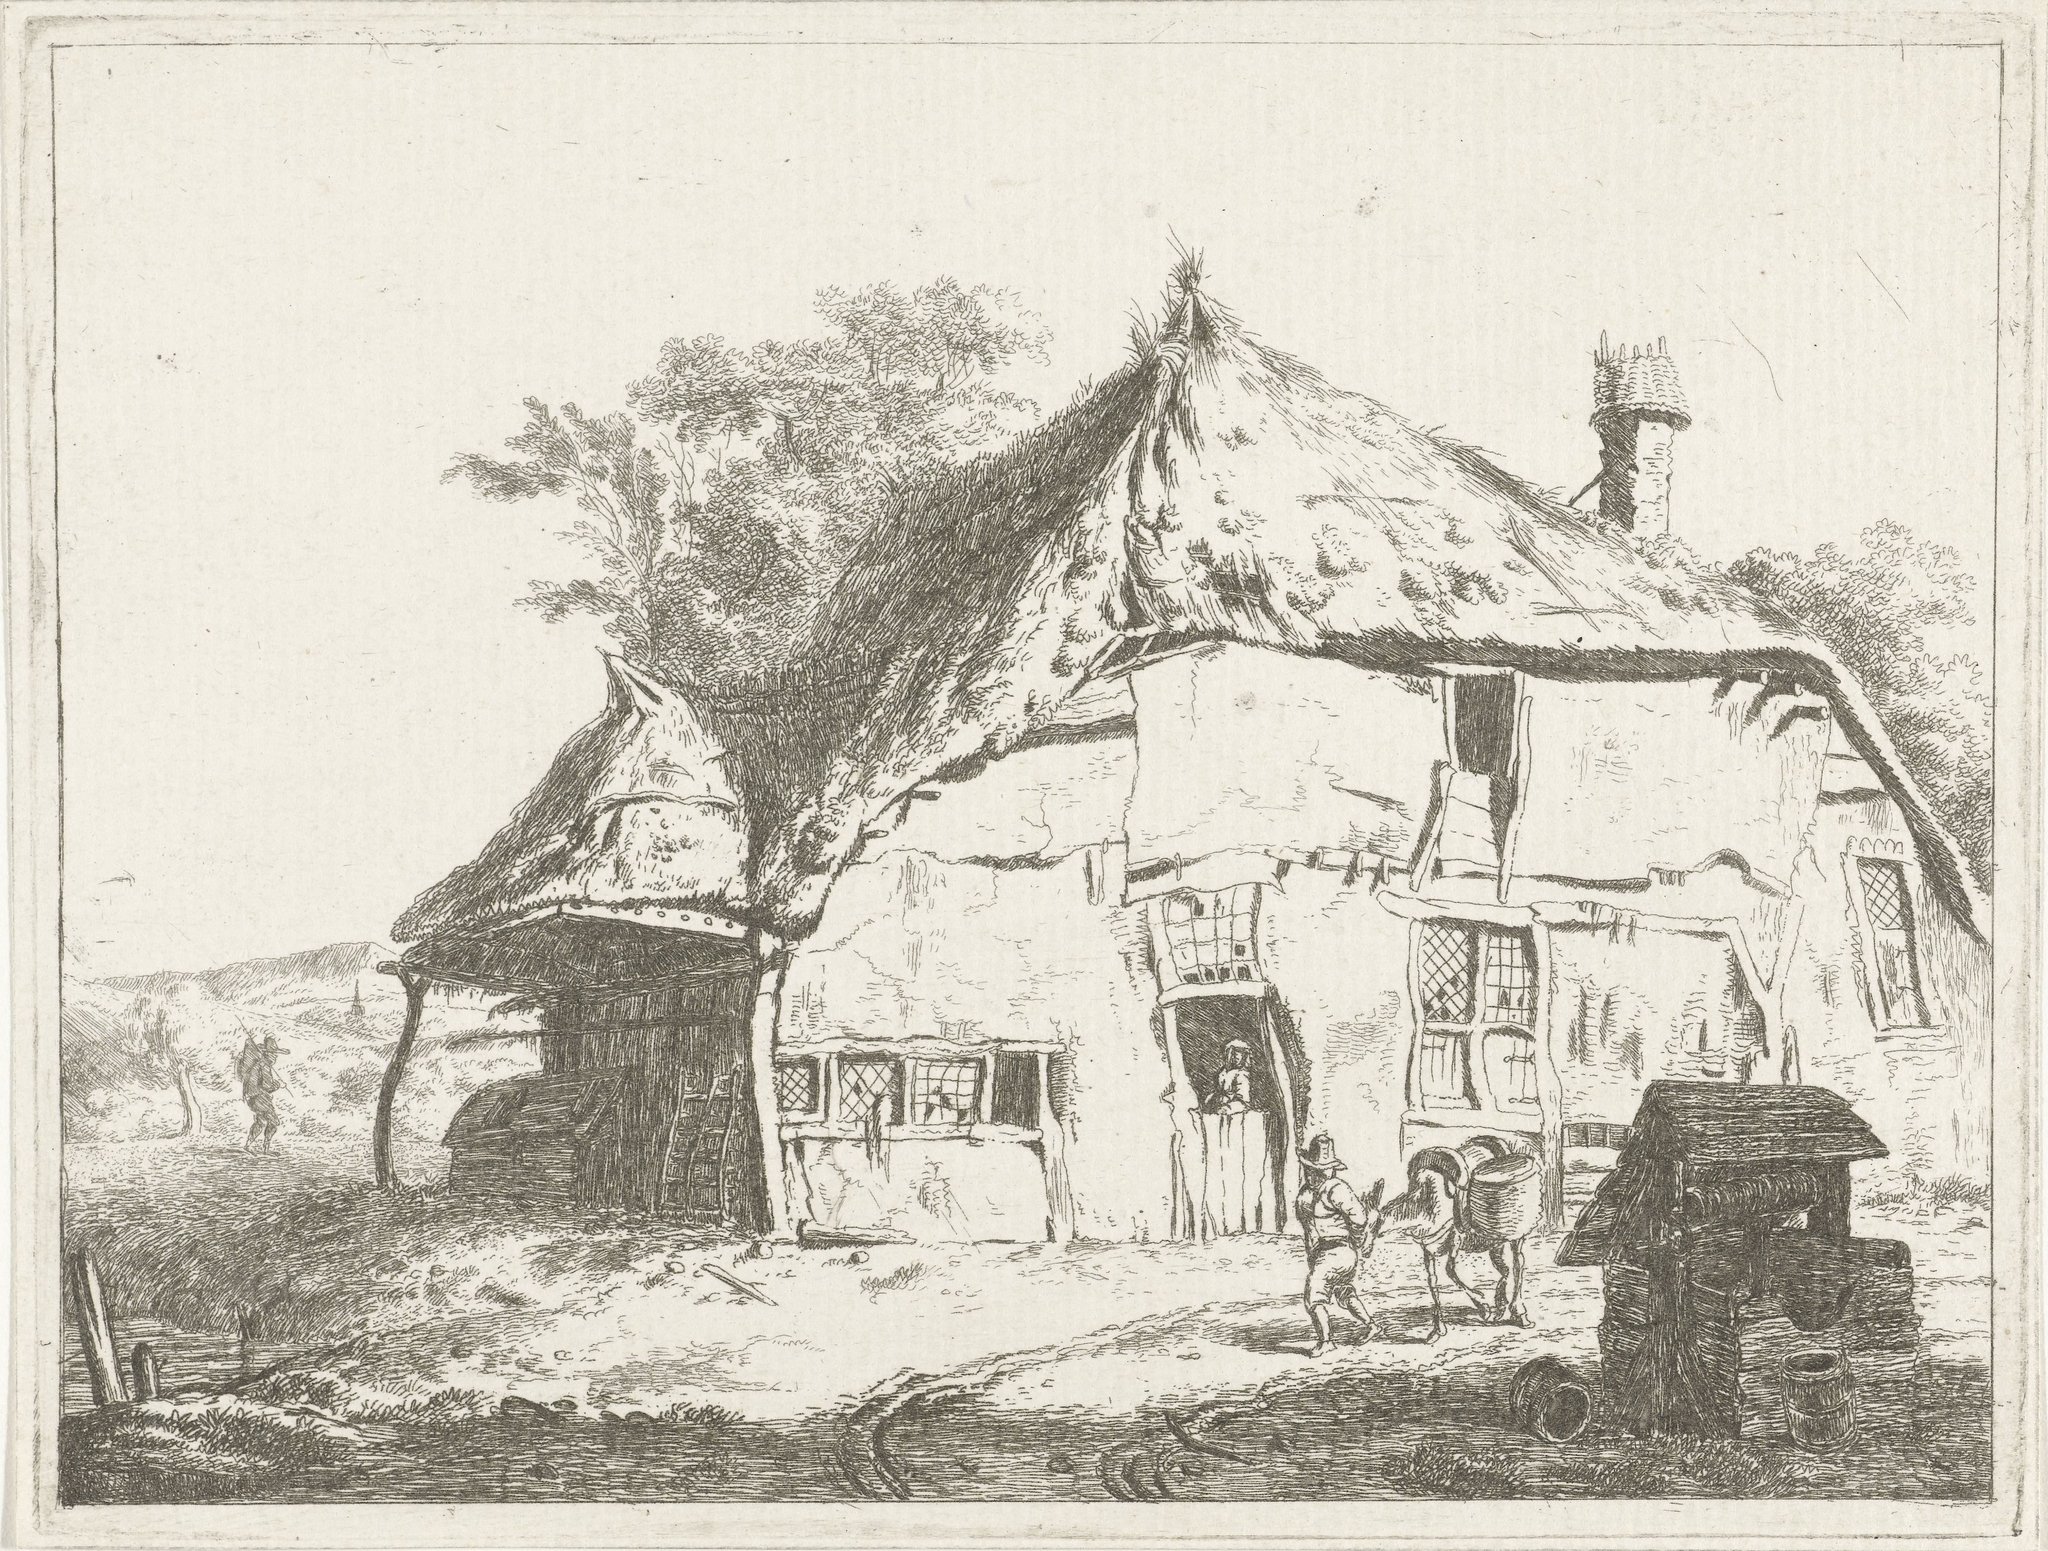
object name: print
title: Boerderij bij een waterput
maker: jabes heenck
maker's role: draughtsman, print maker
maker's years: 1752-1782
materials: paper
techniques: etching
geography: northern netherlands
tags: well, ass, donkey, farm or solitary house in landscape (+ city(-scape) with figures, staffage)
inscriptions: collector's mark: Lugt 2228